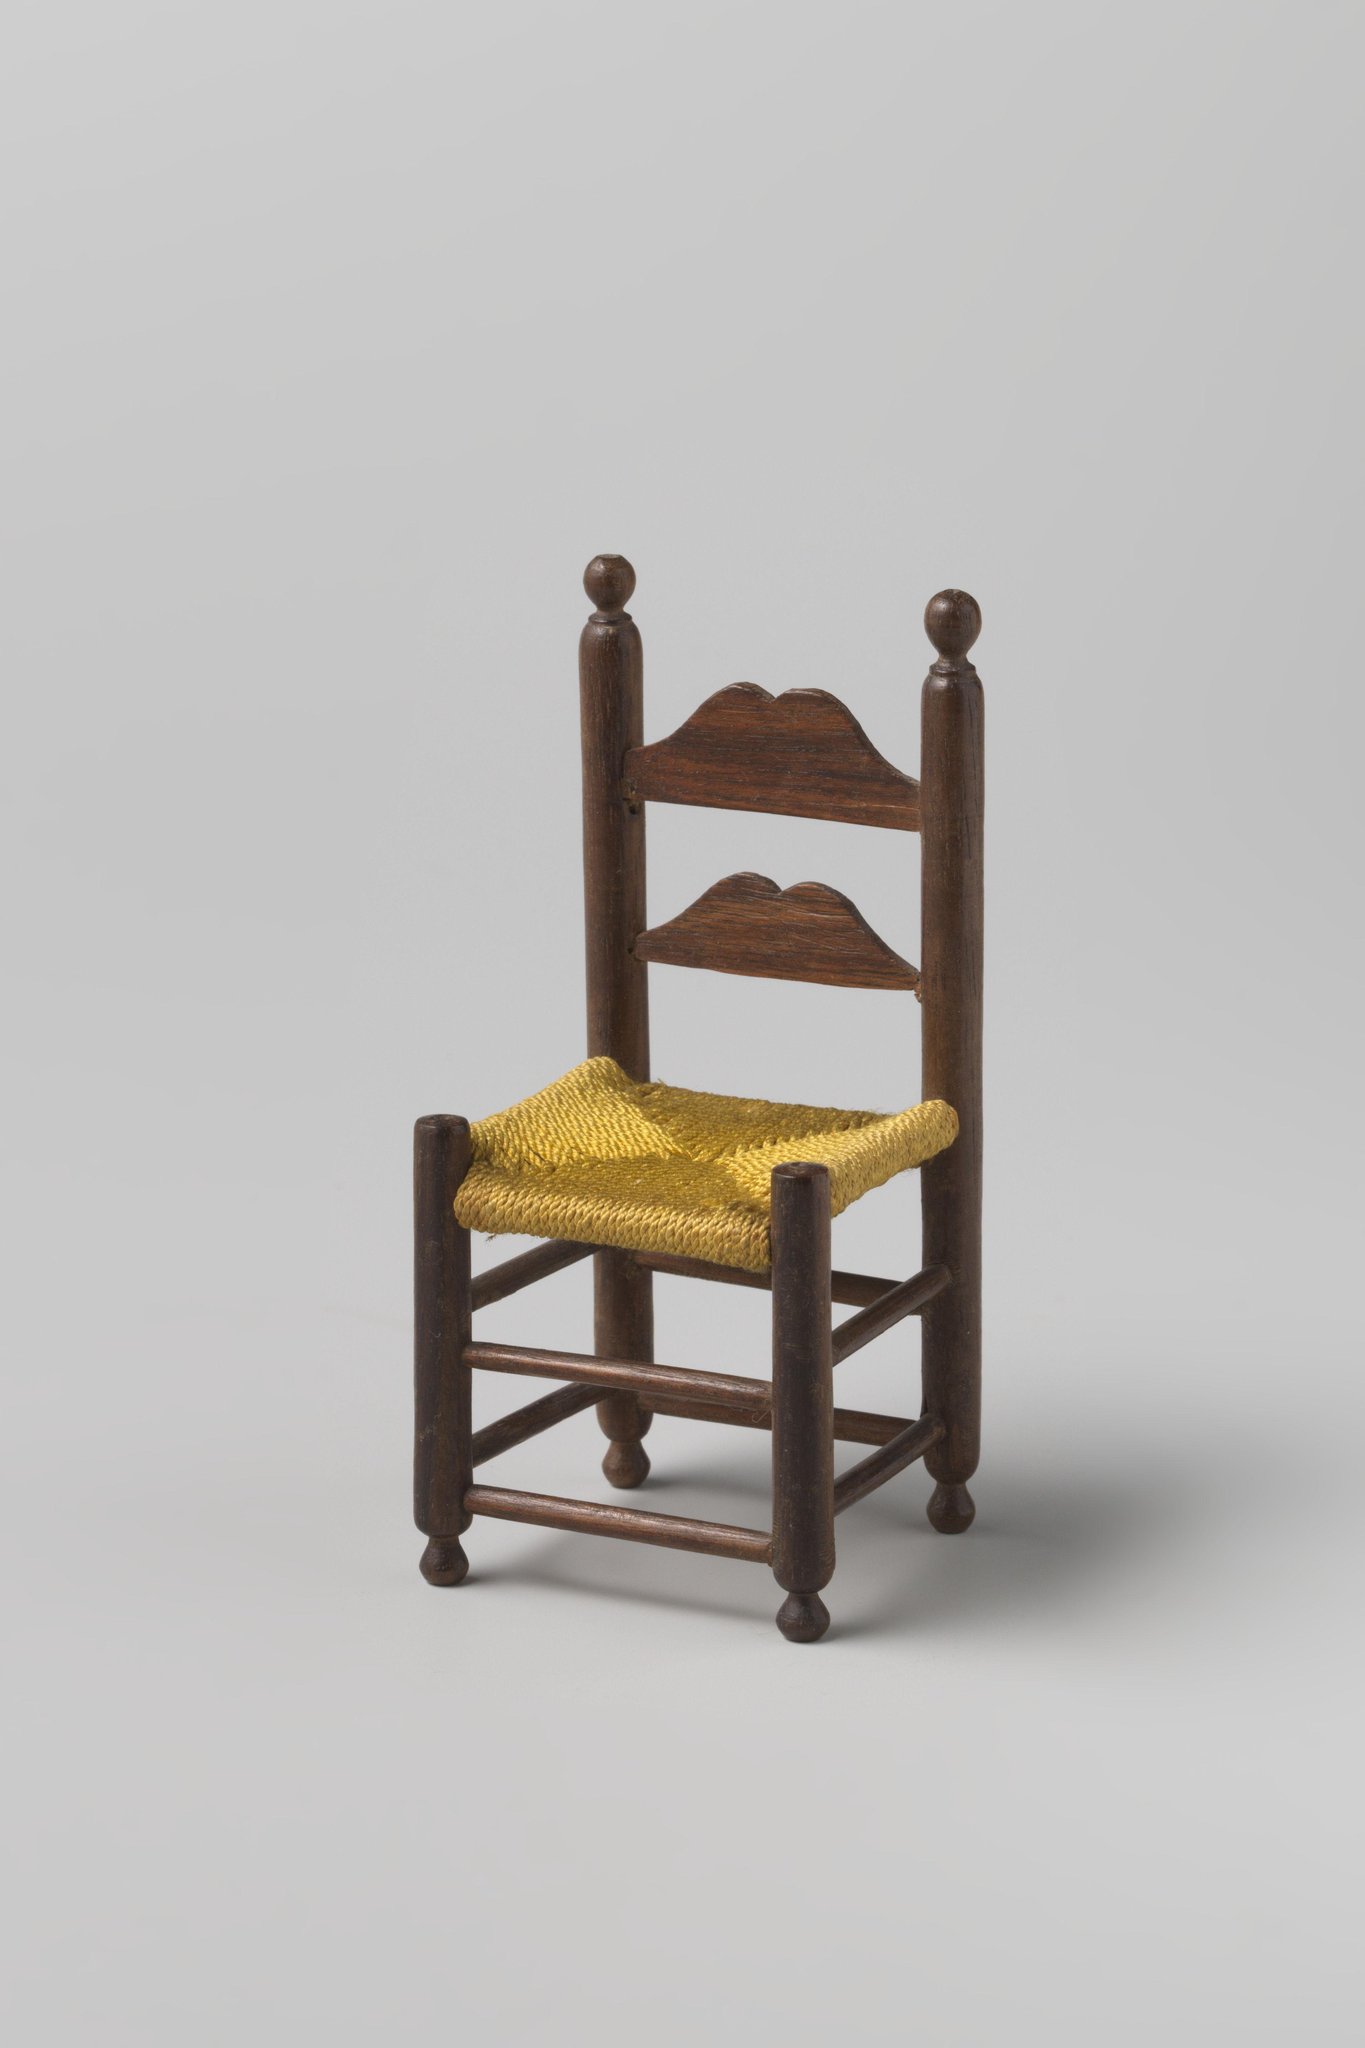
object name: miniature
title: Stoel van notenhout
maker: Anonymous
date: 1676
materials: silk, wood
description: Stoel van notenhout met gladde gedraaide stijlen en dwarsregels. De poten en rugstijlen eindigend in bollen. De rugleuning met twee platte dwarssporten in dubbele boog gezaagd. De zitting imitatie mattenbies, gevlochten van geel, getwist zijden koord.